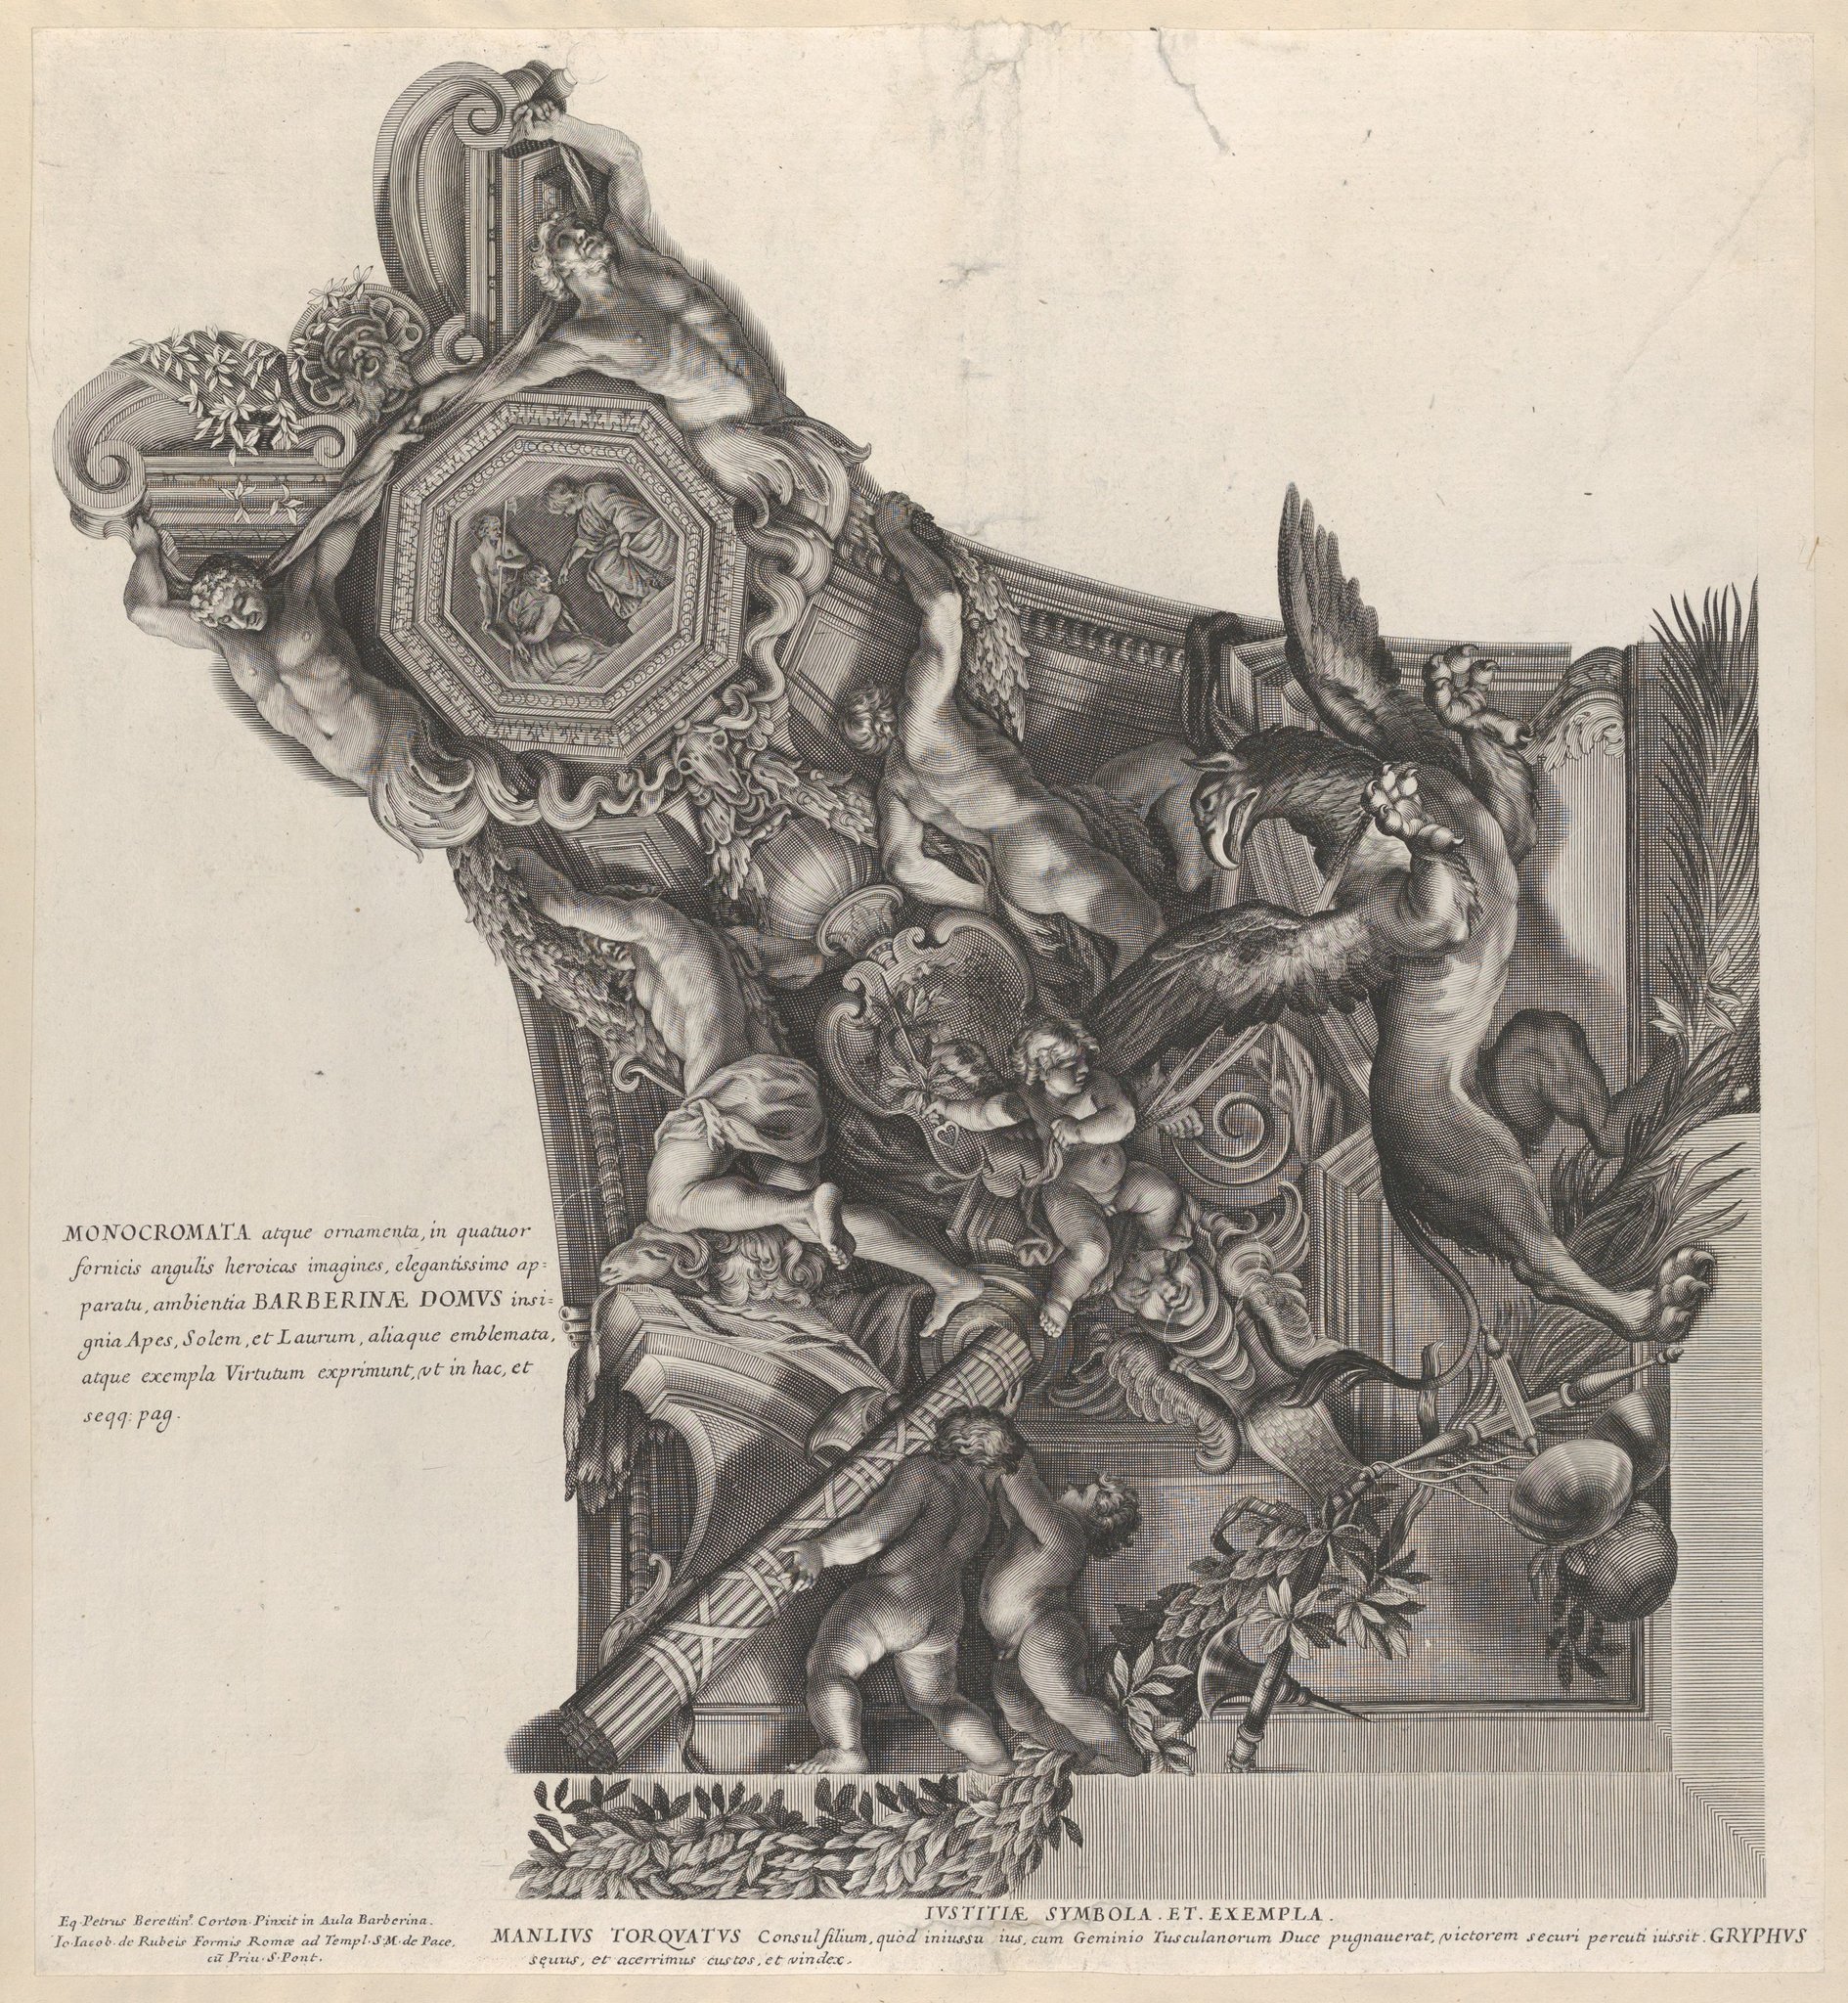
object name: print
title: Plate 7: Allegory of Justice with griffin of Manlius Toquatus, from "Barberinae aulae fornix"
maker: anonymous, italian, 17th century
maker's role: artist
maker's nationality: italian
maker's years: 1600-1700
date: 1677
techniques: engraving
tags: ornament,children,men,griffins